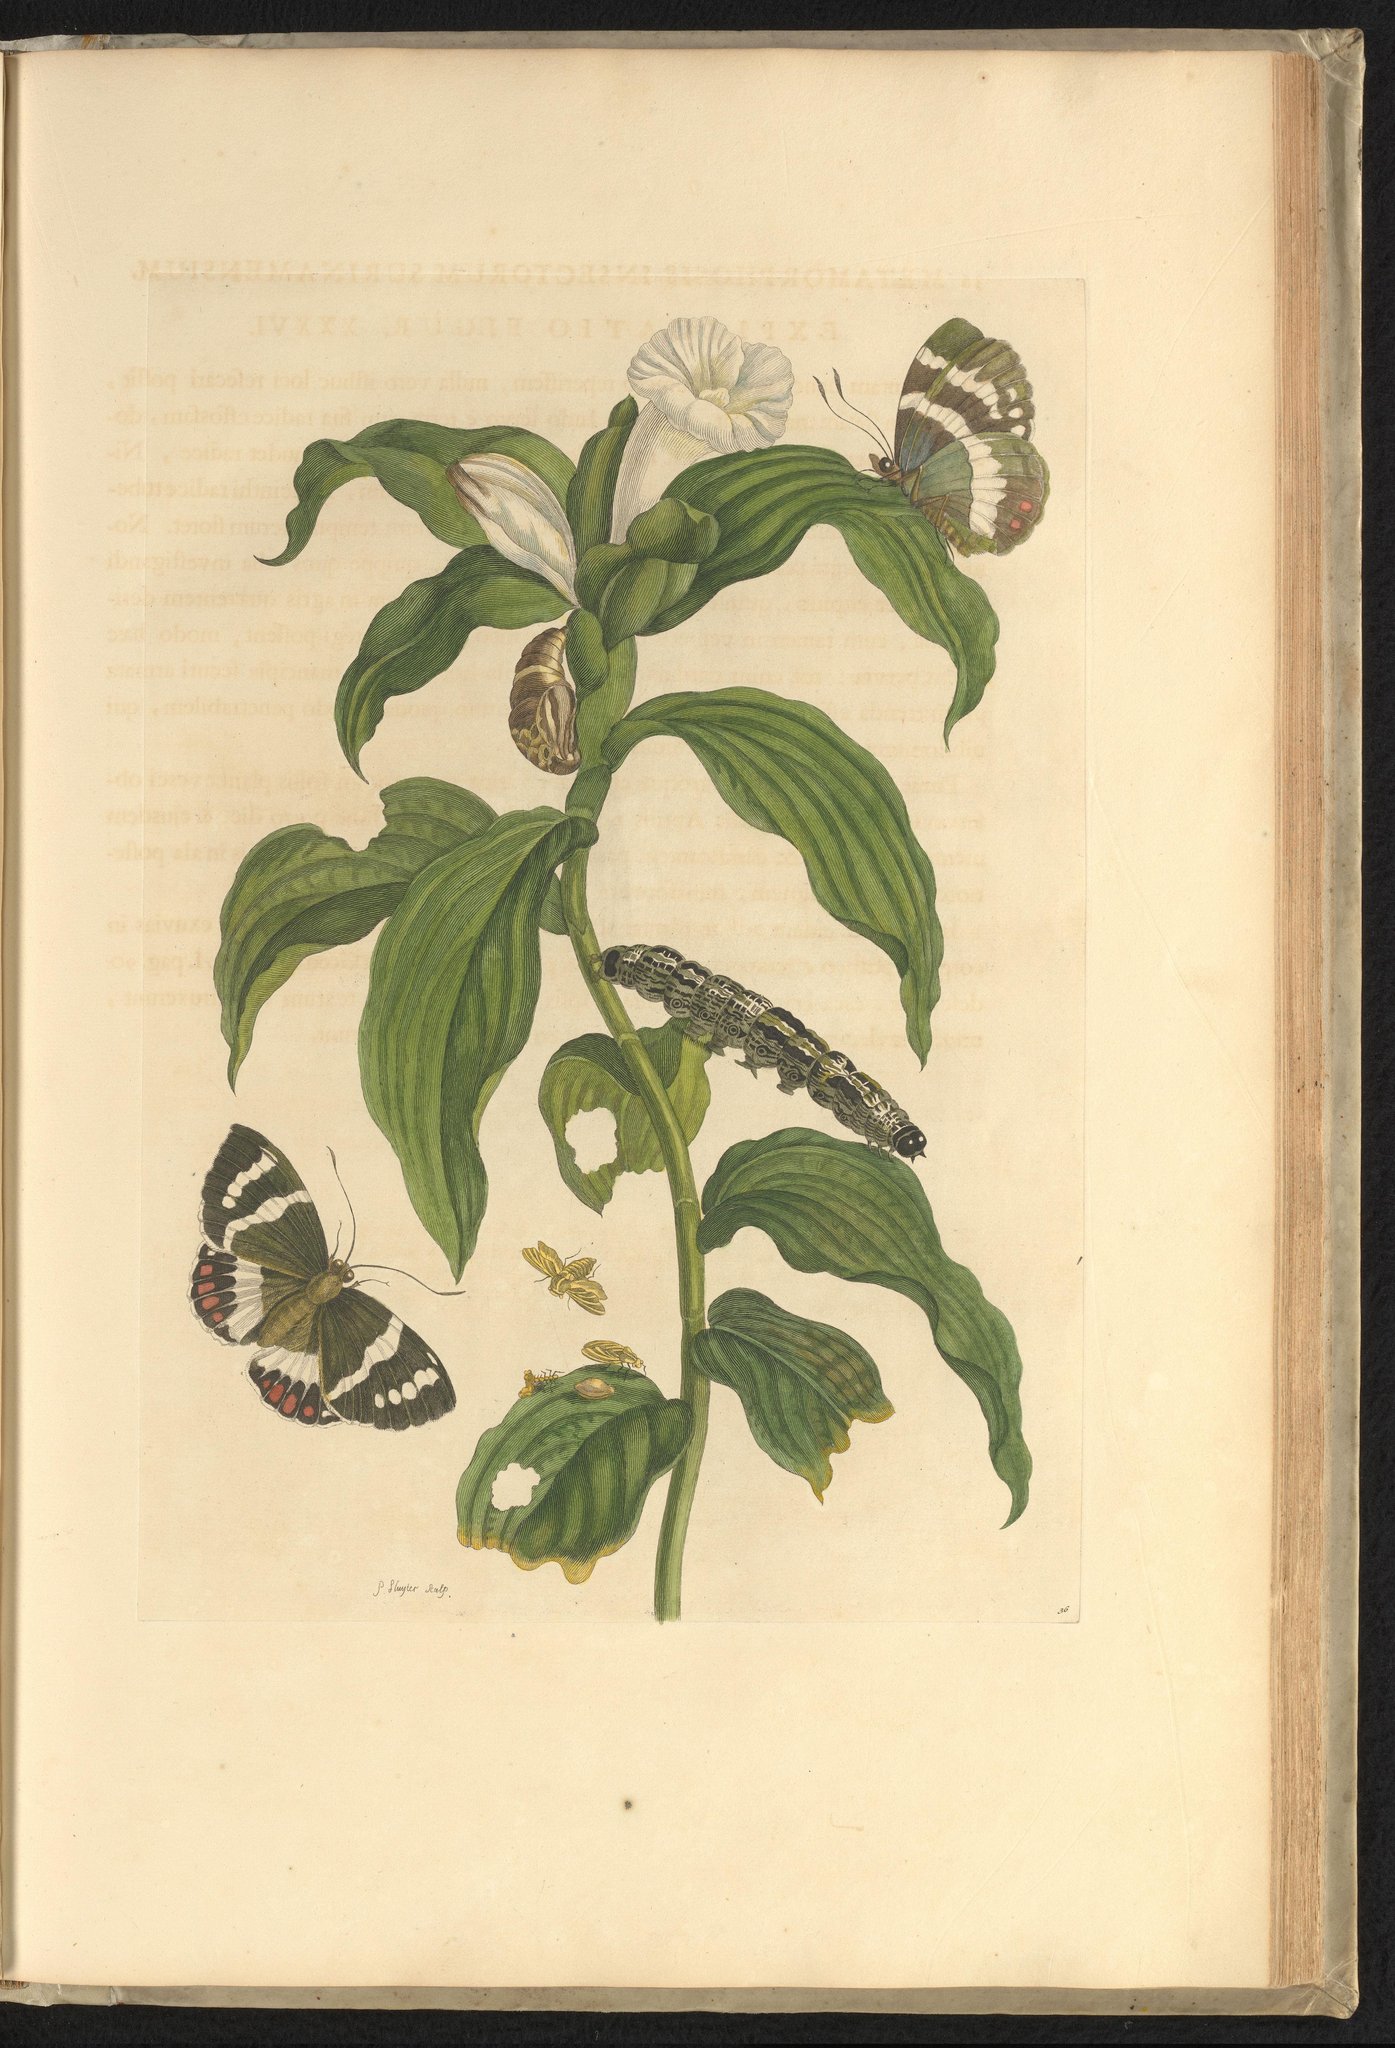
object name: print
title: Wenteltrap (Costus arabicus) met twee vlinders, rups, pop en andere insecten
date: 1705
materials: paper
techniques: etching, hand coloring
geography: suriname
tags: insects: pupa, insects: butterfly, insects: caterpillar, plants and herbs, suriname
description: Rechtsonder genummerd: 36. Prent maakt deel uit van een boek.